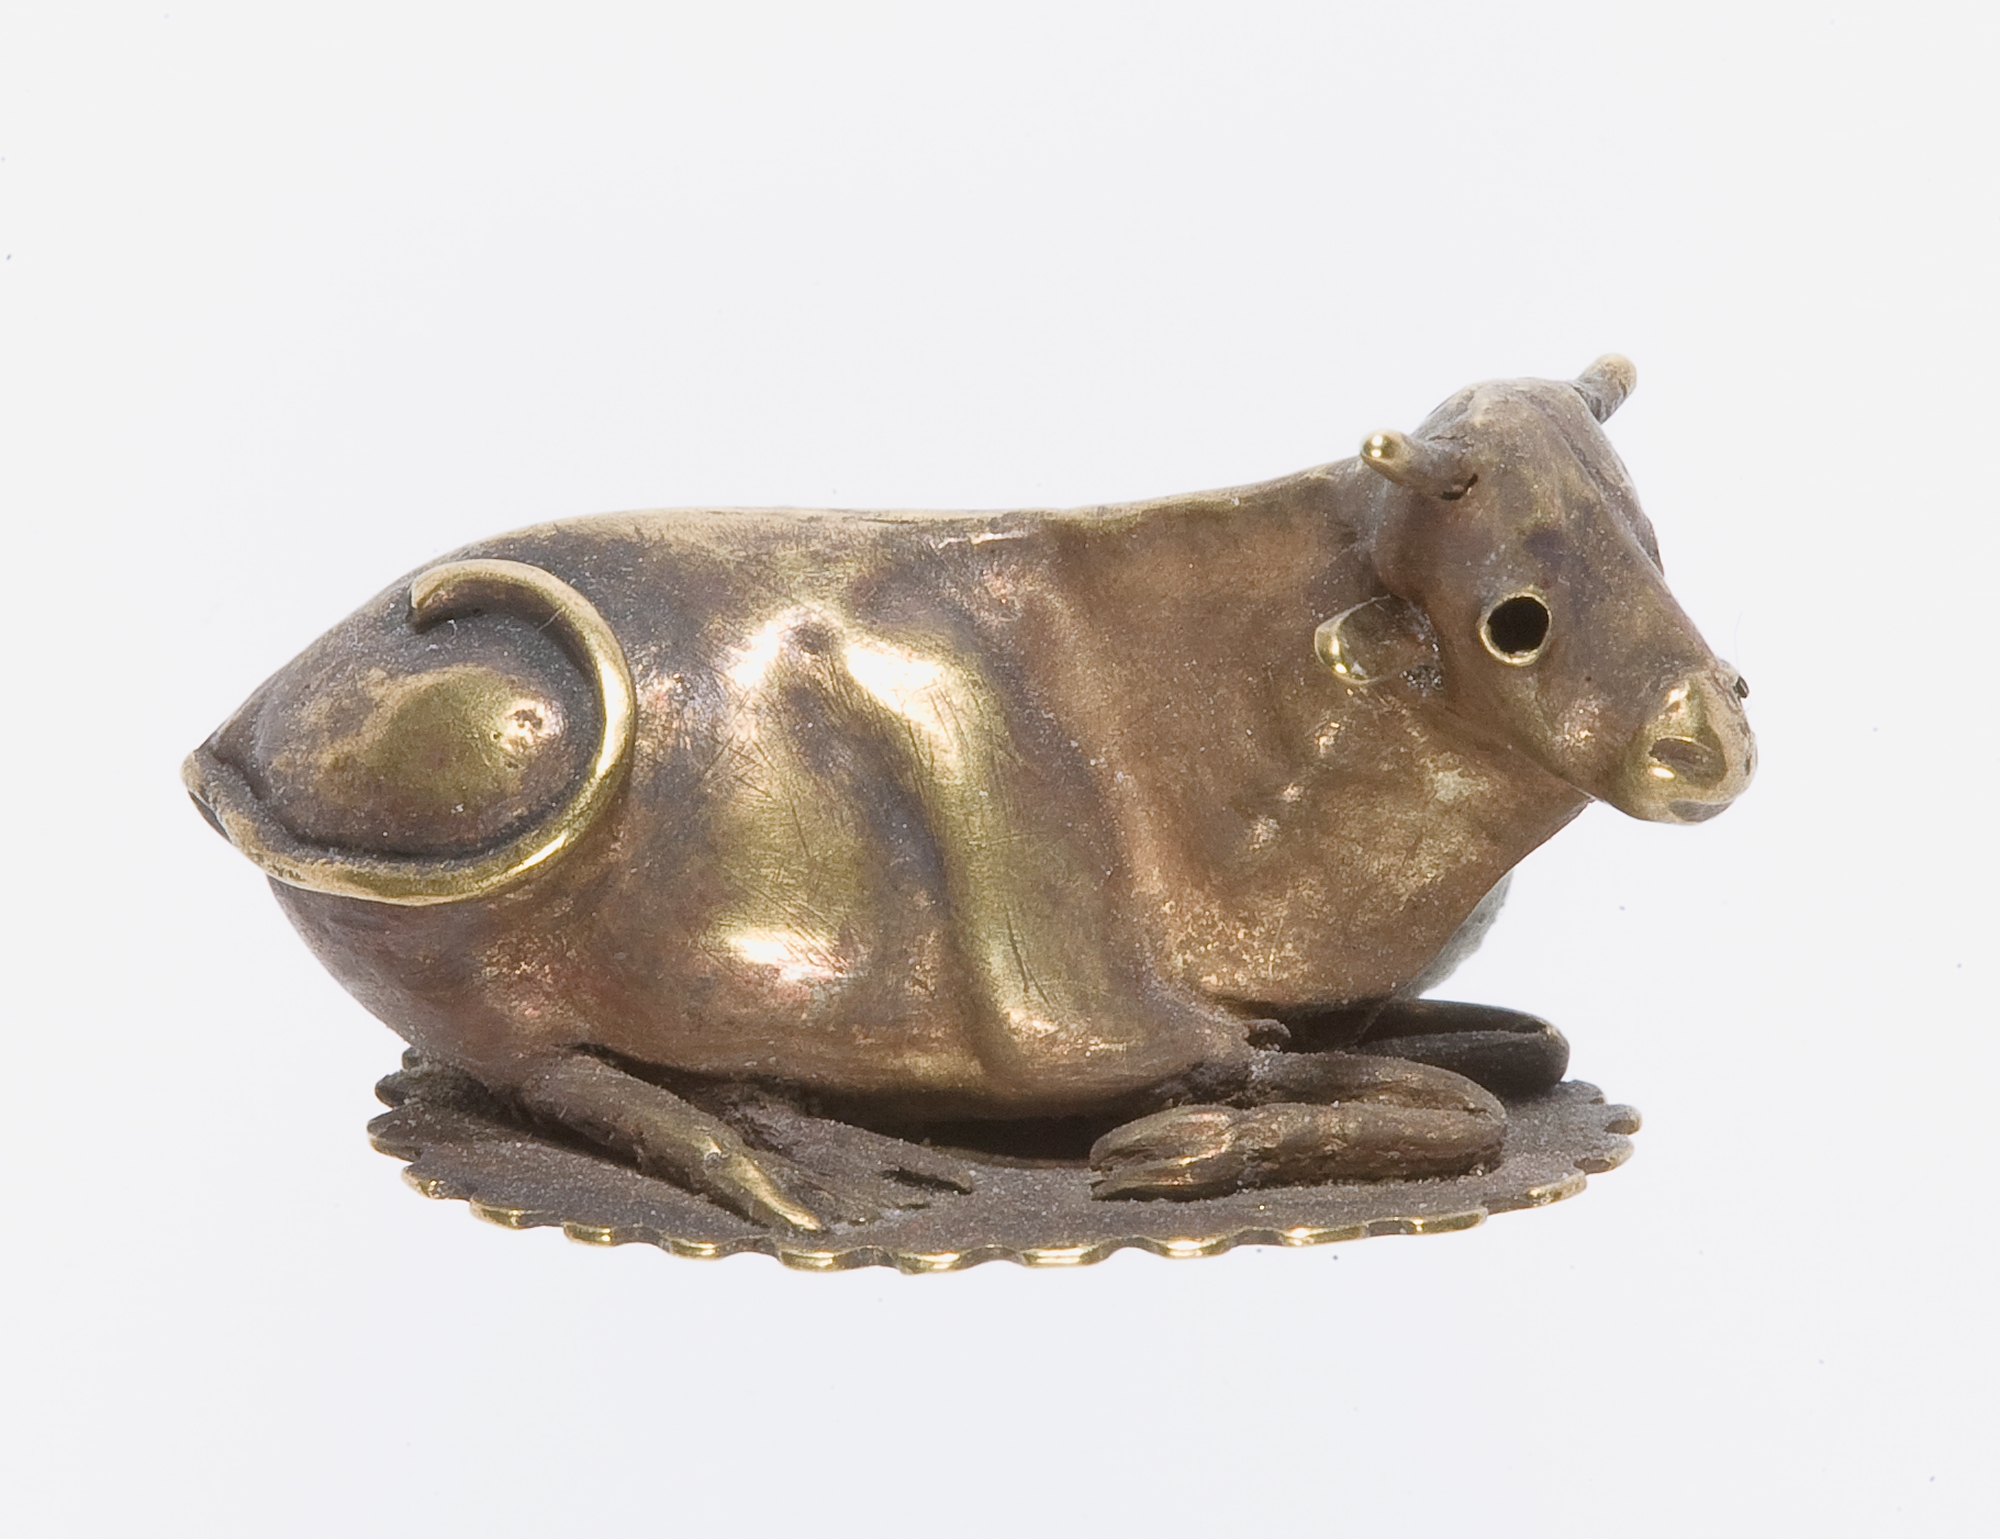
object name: amulet, bovine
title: Resting bovine amulet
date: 664-380 BCE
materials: gold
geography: egypt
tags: cows